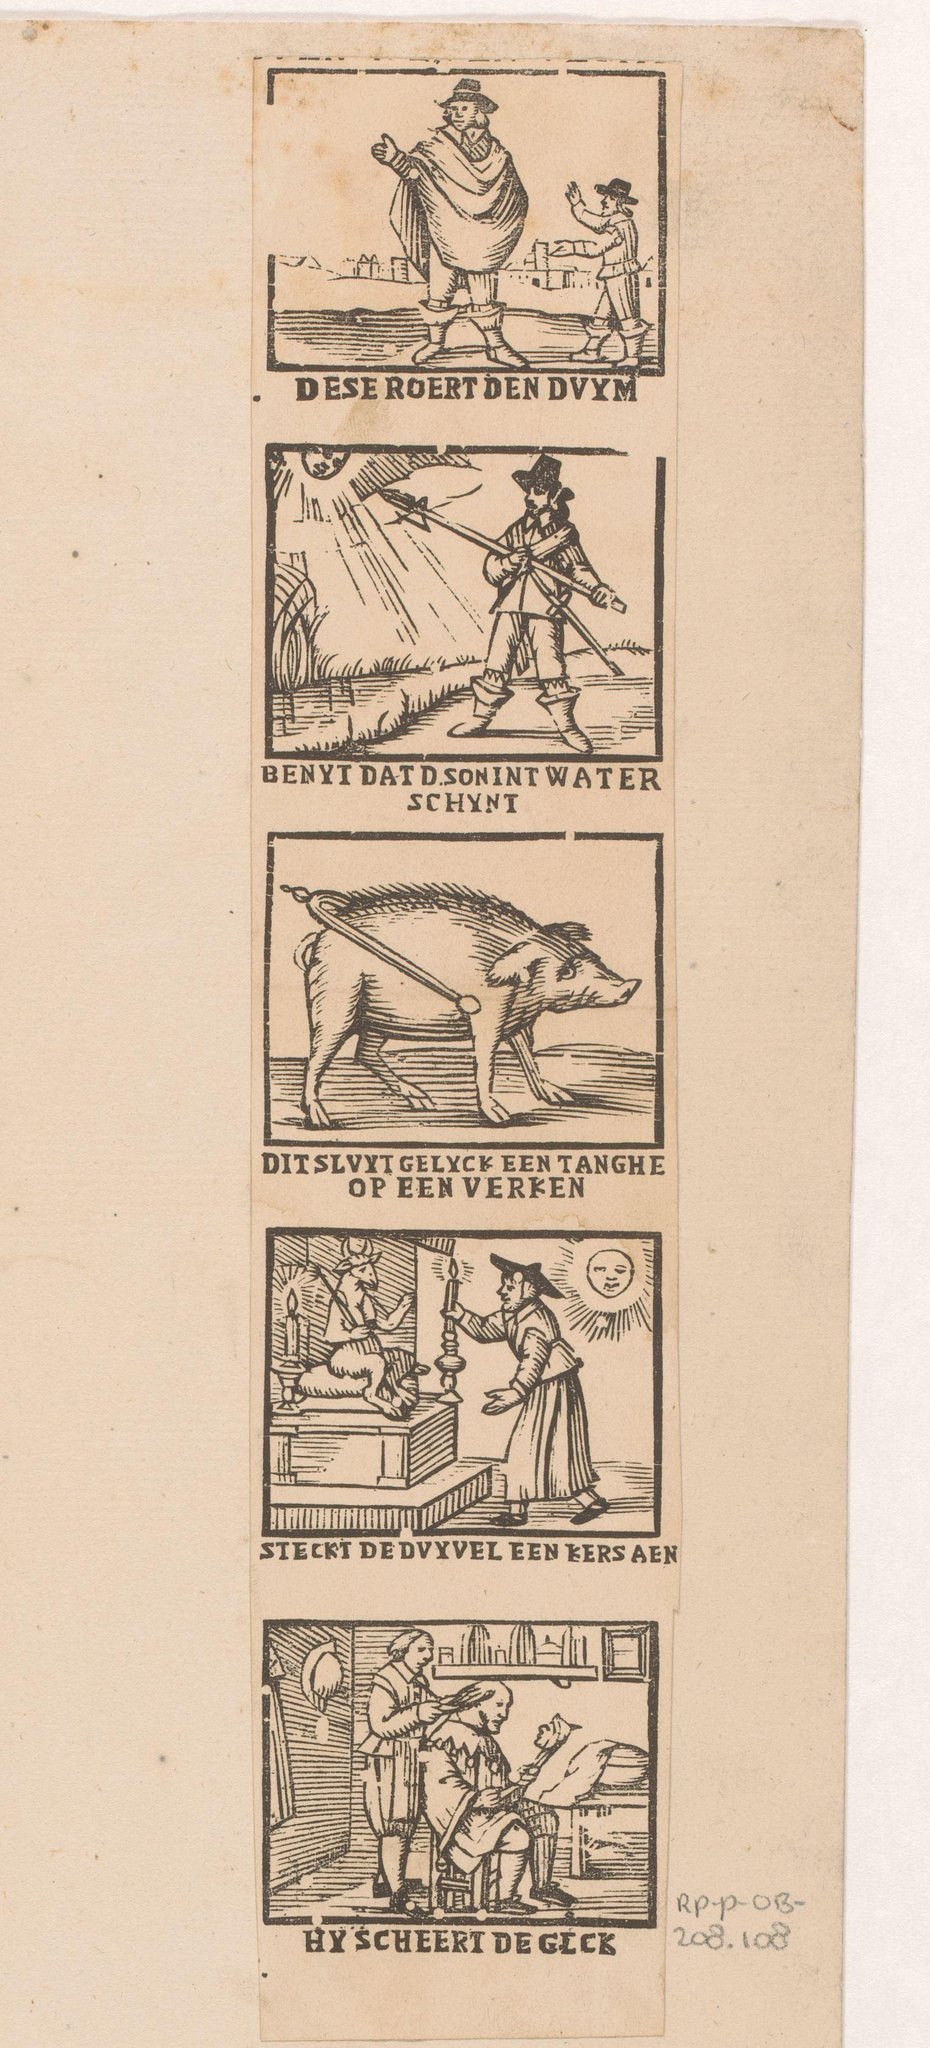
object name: print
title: Afbeeldingh hoe seven wyven vechten om een mans broeck ende de vrou de broeck aentrecht [(...)]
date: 1700-1725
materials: paper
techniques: woodcut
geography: low countries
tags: proverbs, sayings, etc.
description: Blad met 5 voorstellingen van spreekwoorden, waaronder 'Dese roert den duym' en 'Dit sluyt gelyck een tanghe op een verken'. Onder elke afbeelding een onderschrift.